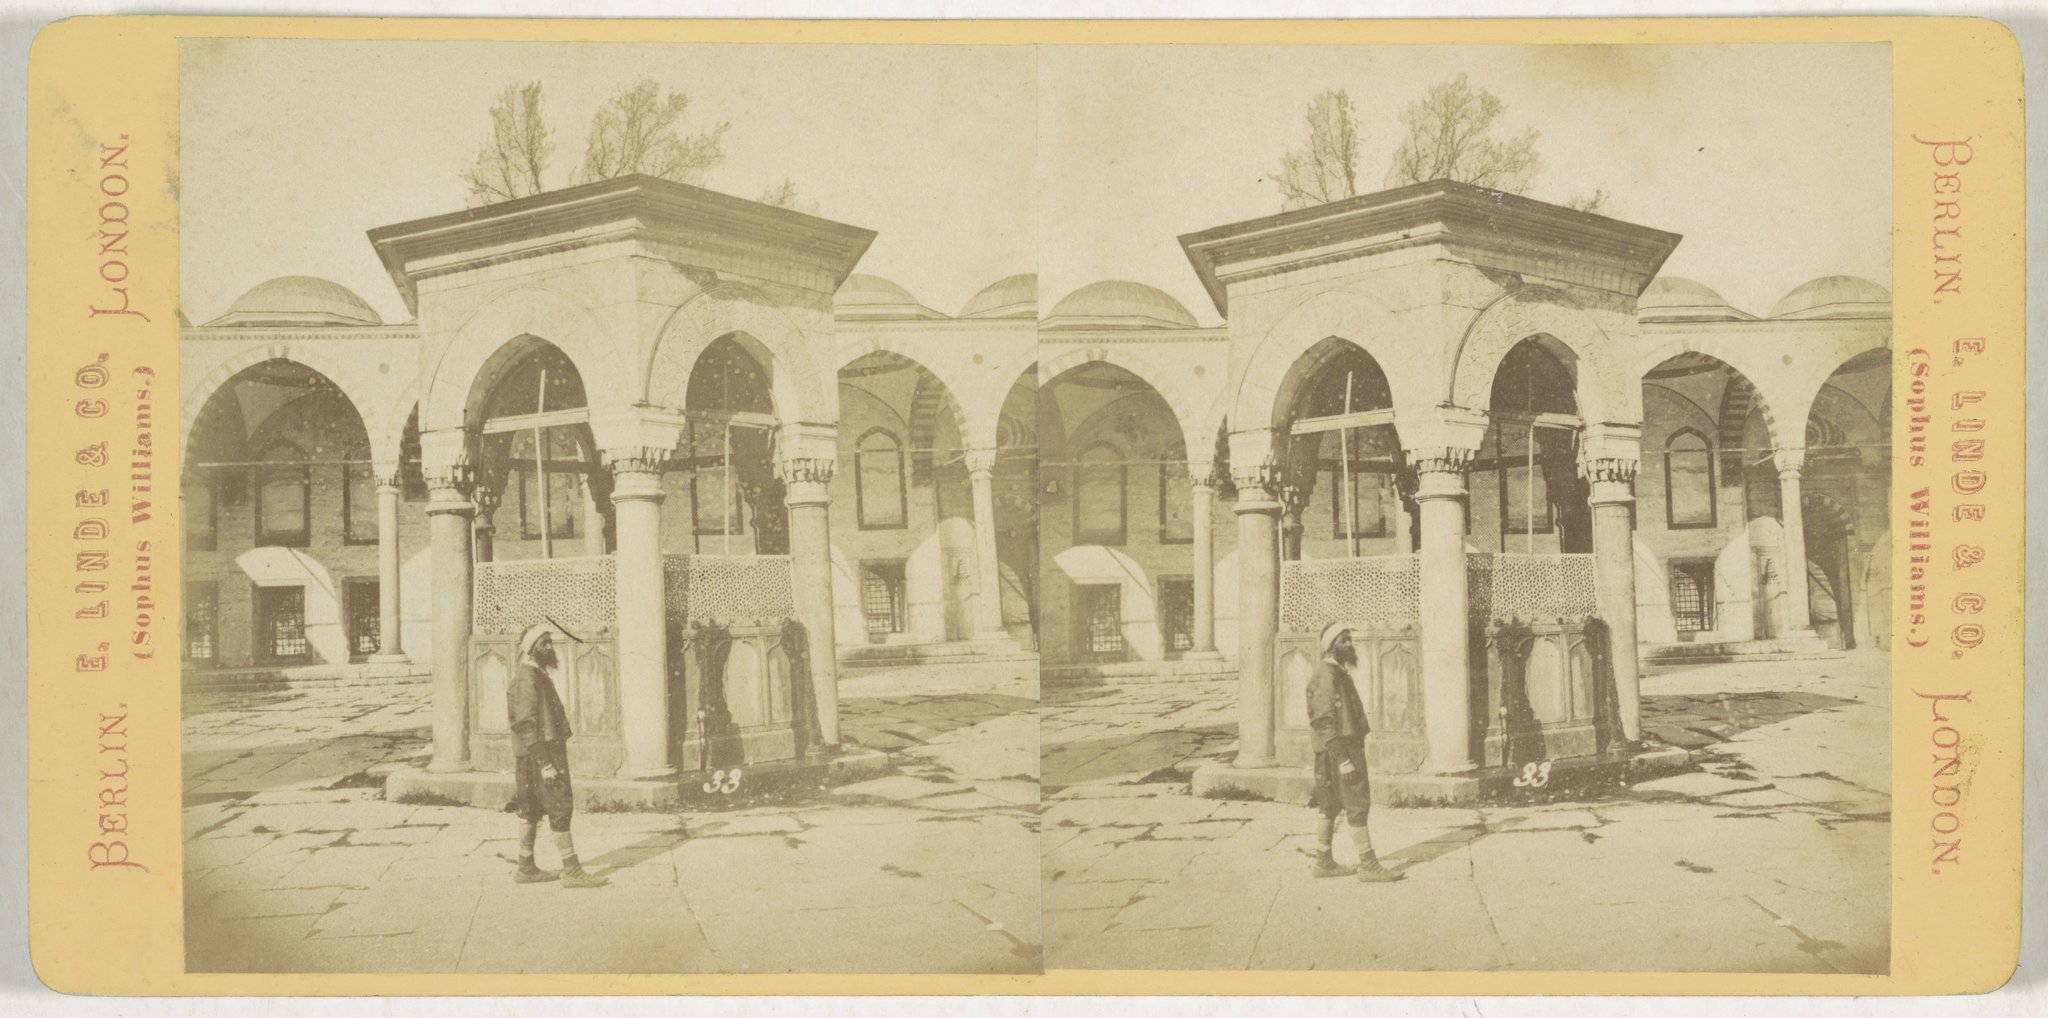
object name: stereograph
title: Constantinopel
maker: Anonymous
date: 1873-1890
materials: cardboard, paper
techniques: albumen print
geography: sultan ahmetmoskee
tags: utilitarian, public pump or water fountain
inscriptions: number: ‘33’